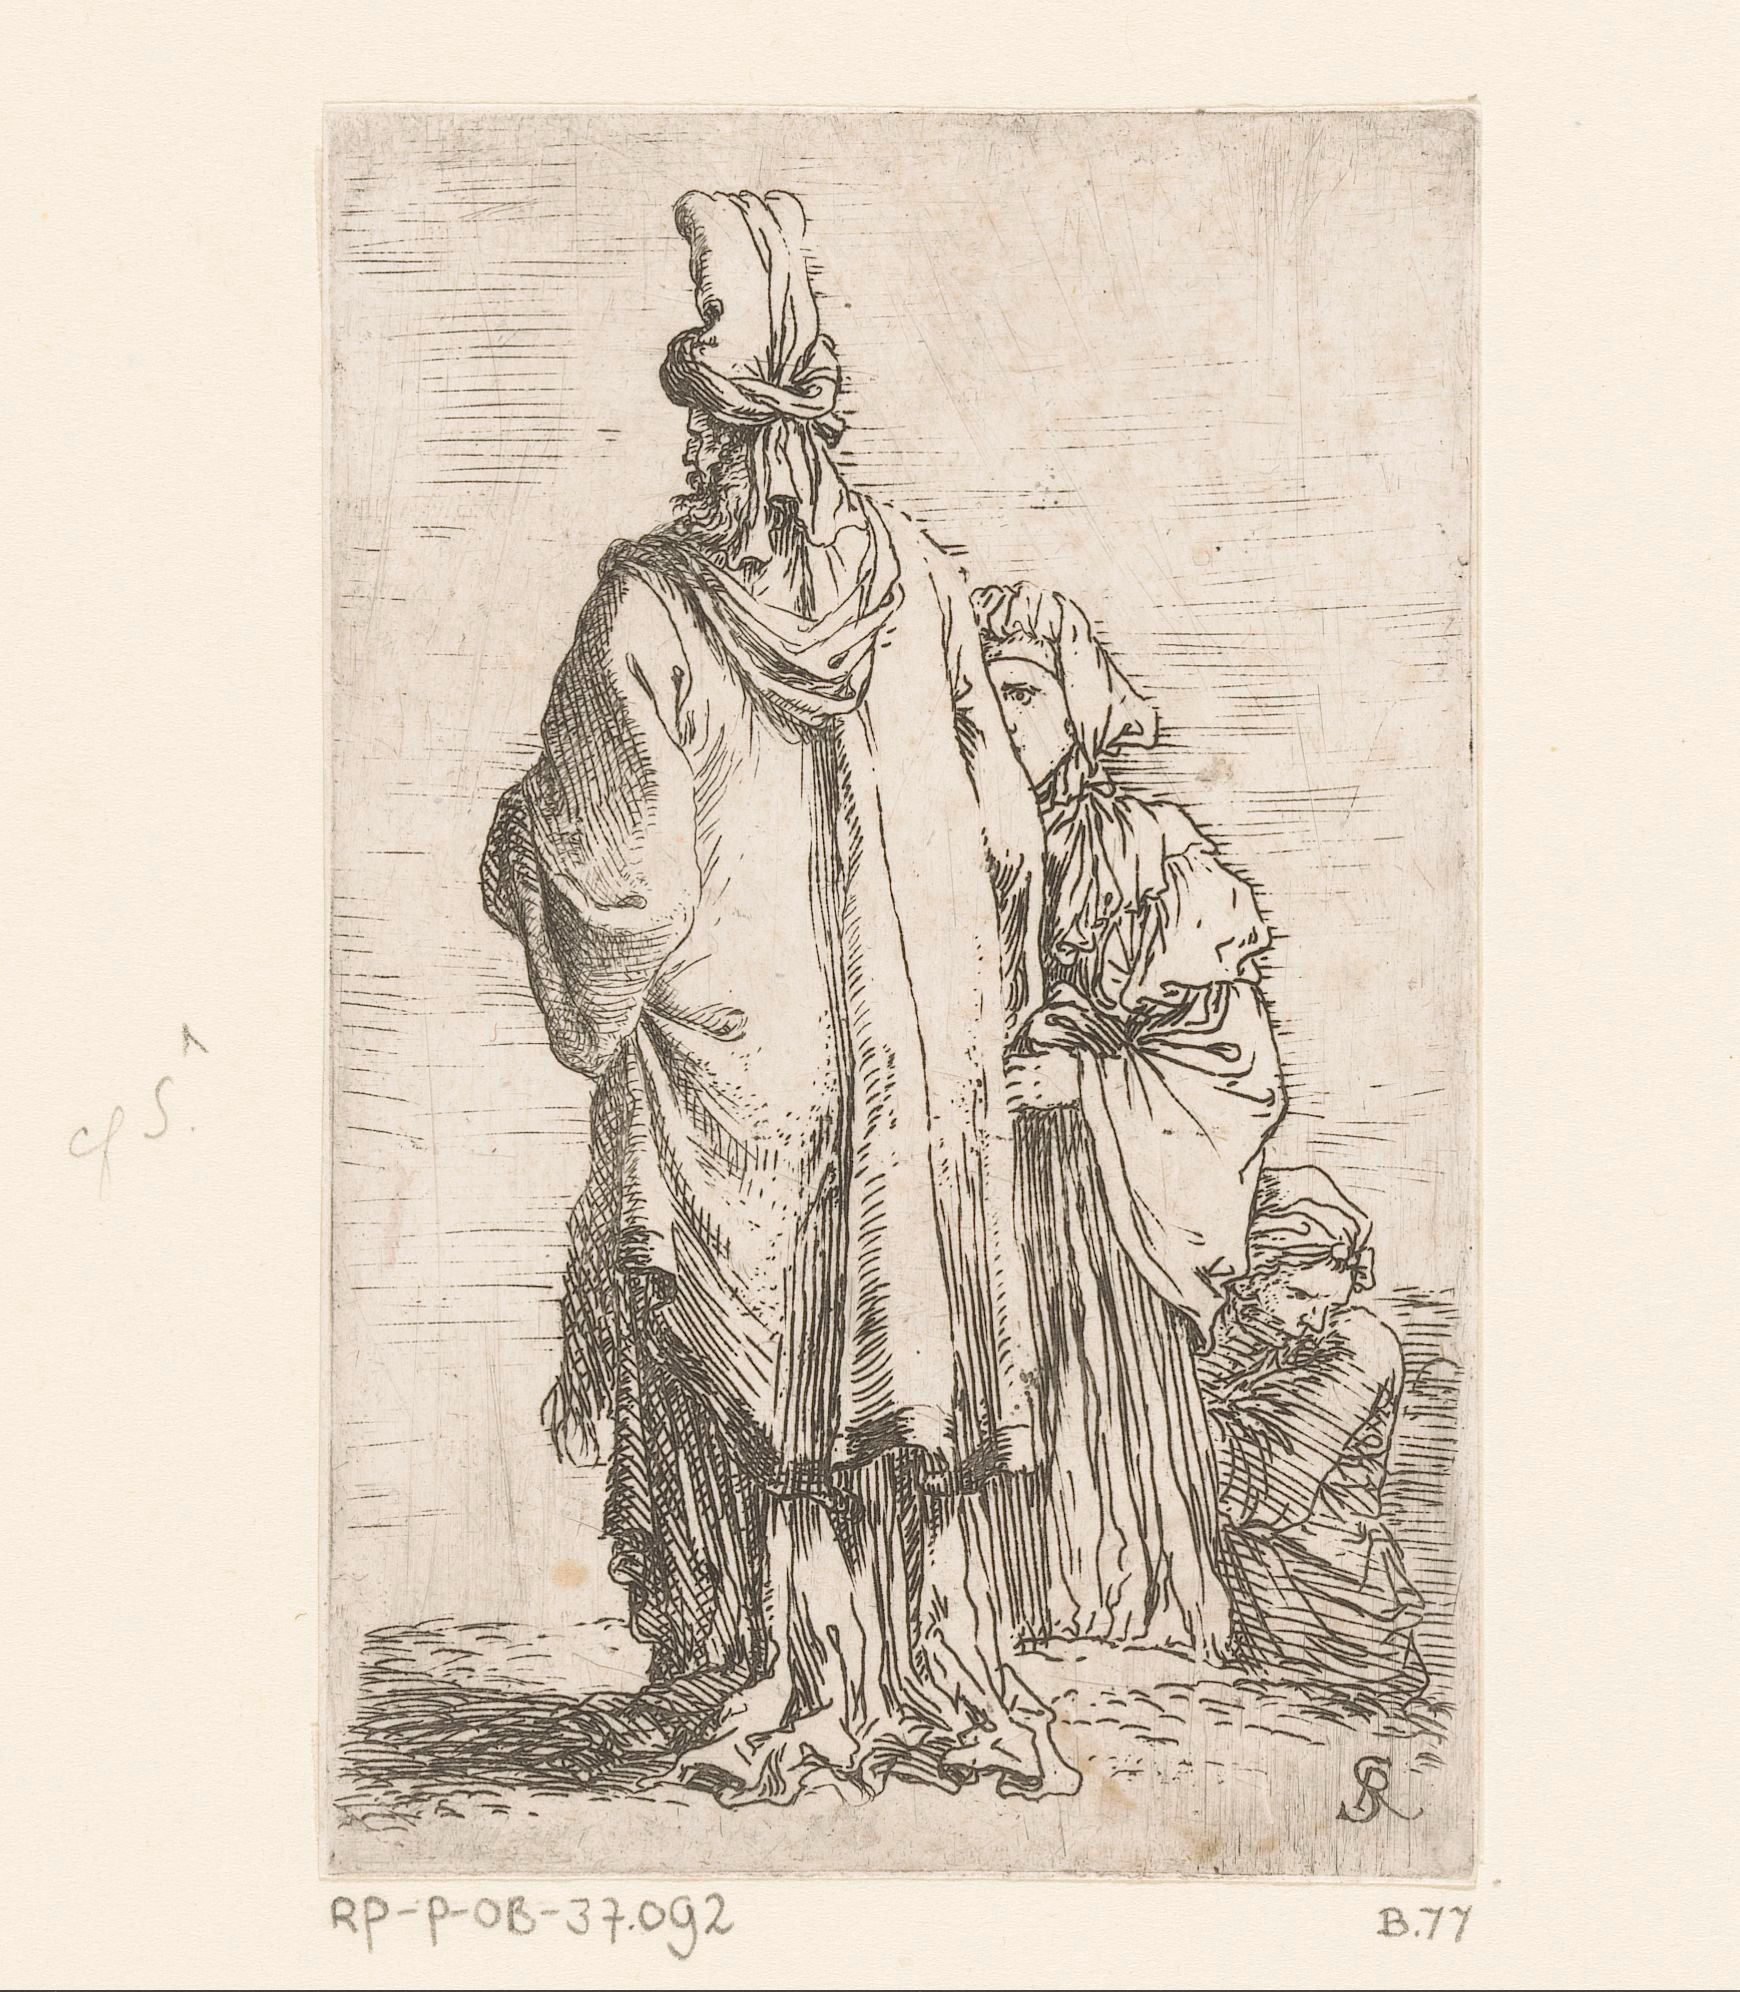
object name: print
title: Figurine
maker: salvator rosa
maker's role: draughtsman, painter, print maker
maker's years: 1615-1673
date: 1656-1657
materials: paper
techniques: drypoint, etching, intaglio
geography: italy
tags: head-gear: turban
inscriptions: collector's mark: Lugt 240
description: Prent spiegelbeeldig naar een tekening in de collectie van Urbano Barberini (voorheen in de collectie van Ladislao Odescalchi te Rome). Deze prent maakt deel uit van de serie 'Figurine', bestaande uit een titelprent en 80 prenten van klein formaat met voorstellingen van mannelijke en vrouwelijke figuren. Rosa produceerde de serie waarschijnlijk gedurende de jaren 1656 en 1657.